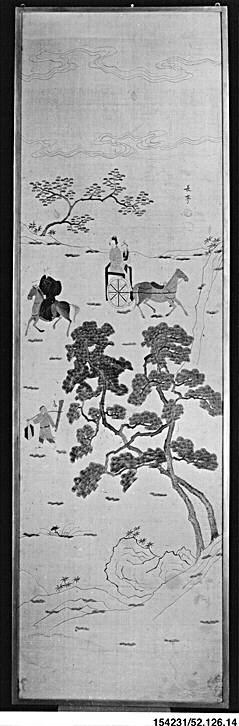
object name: screen panel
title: Screen Panel from Set of Six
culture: chinese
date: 1767-1833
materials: silk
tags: trees,carts